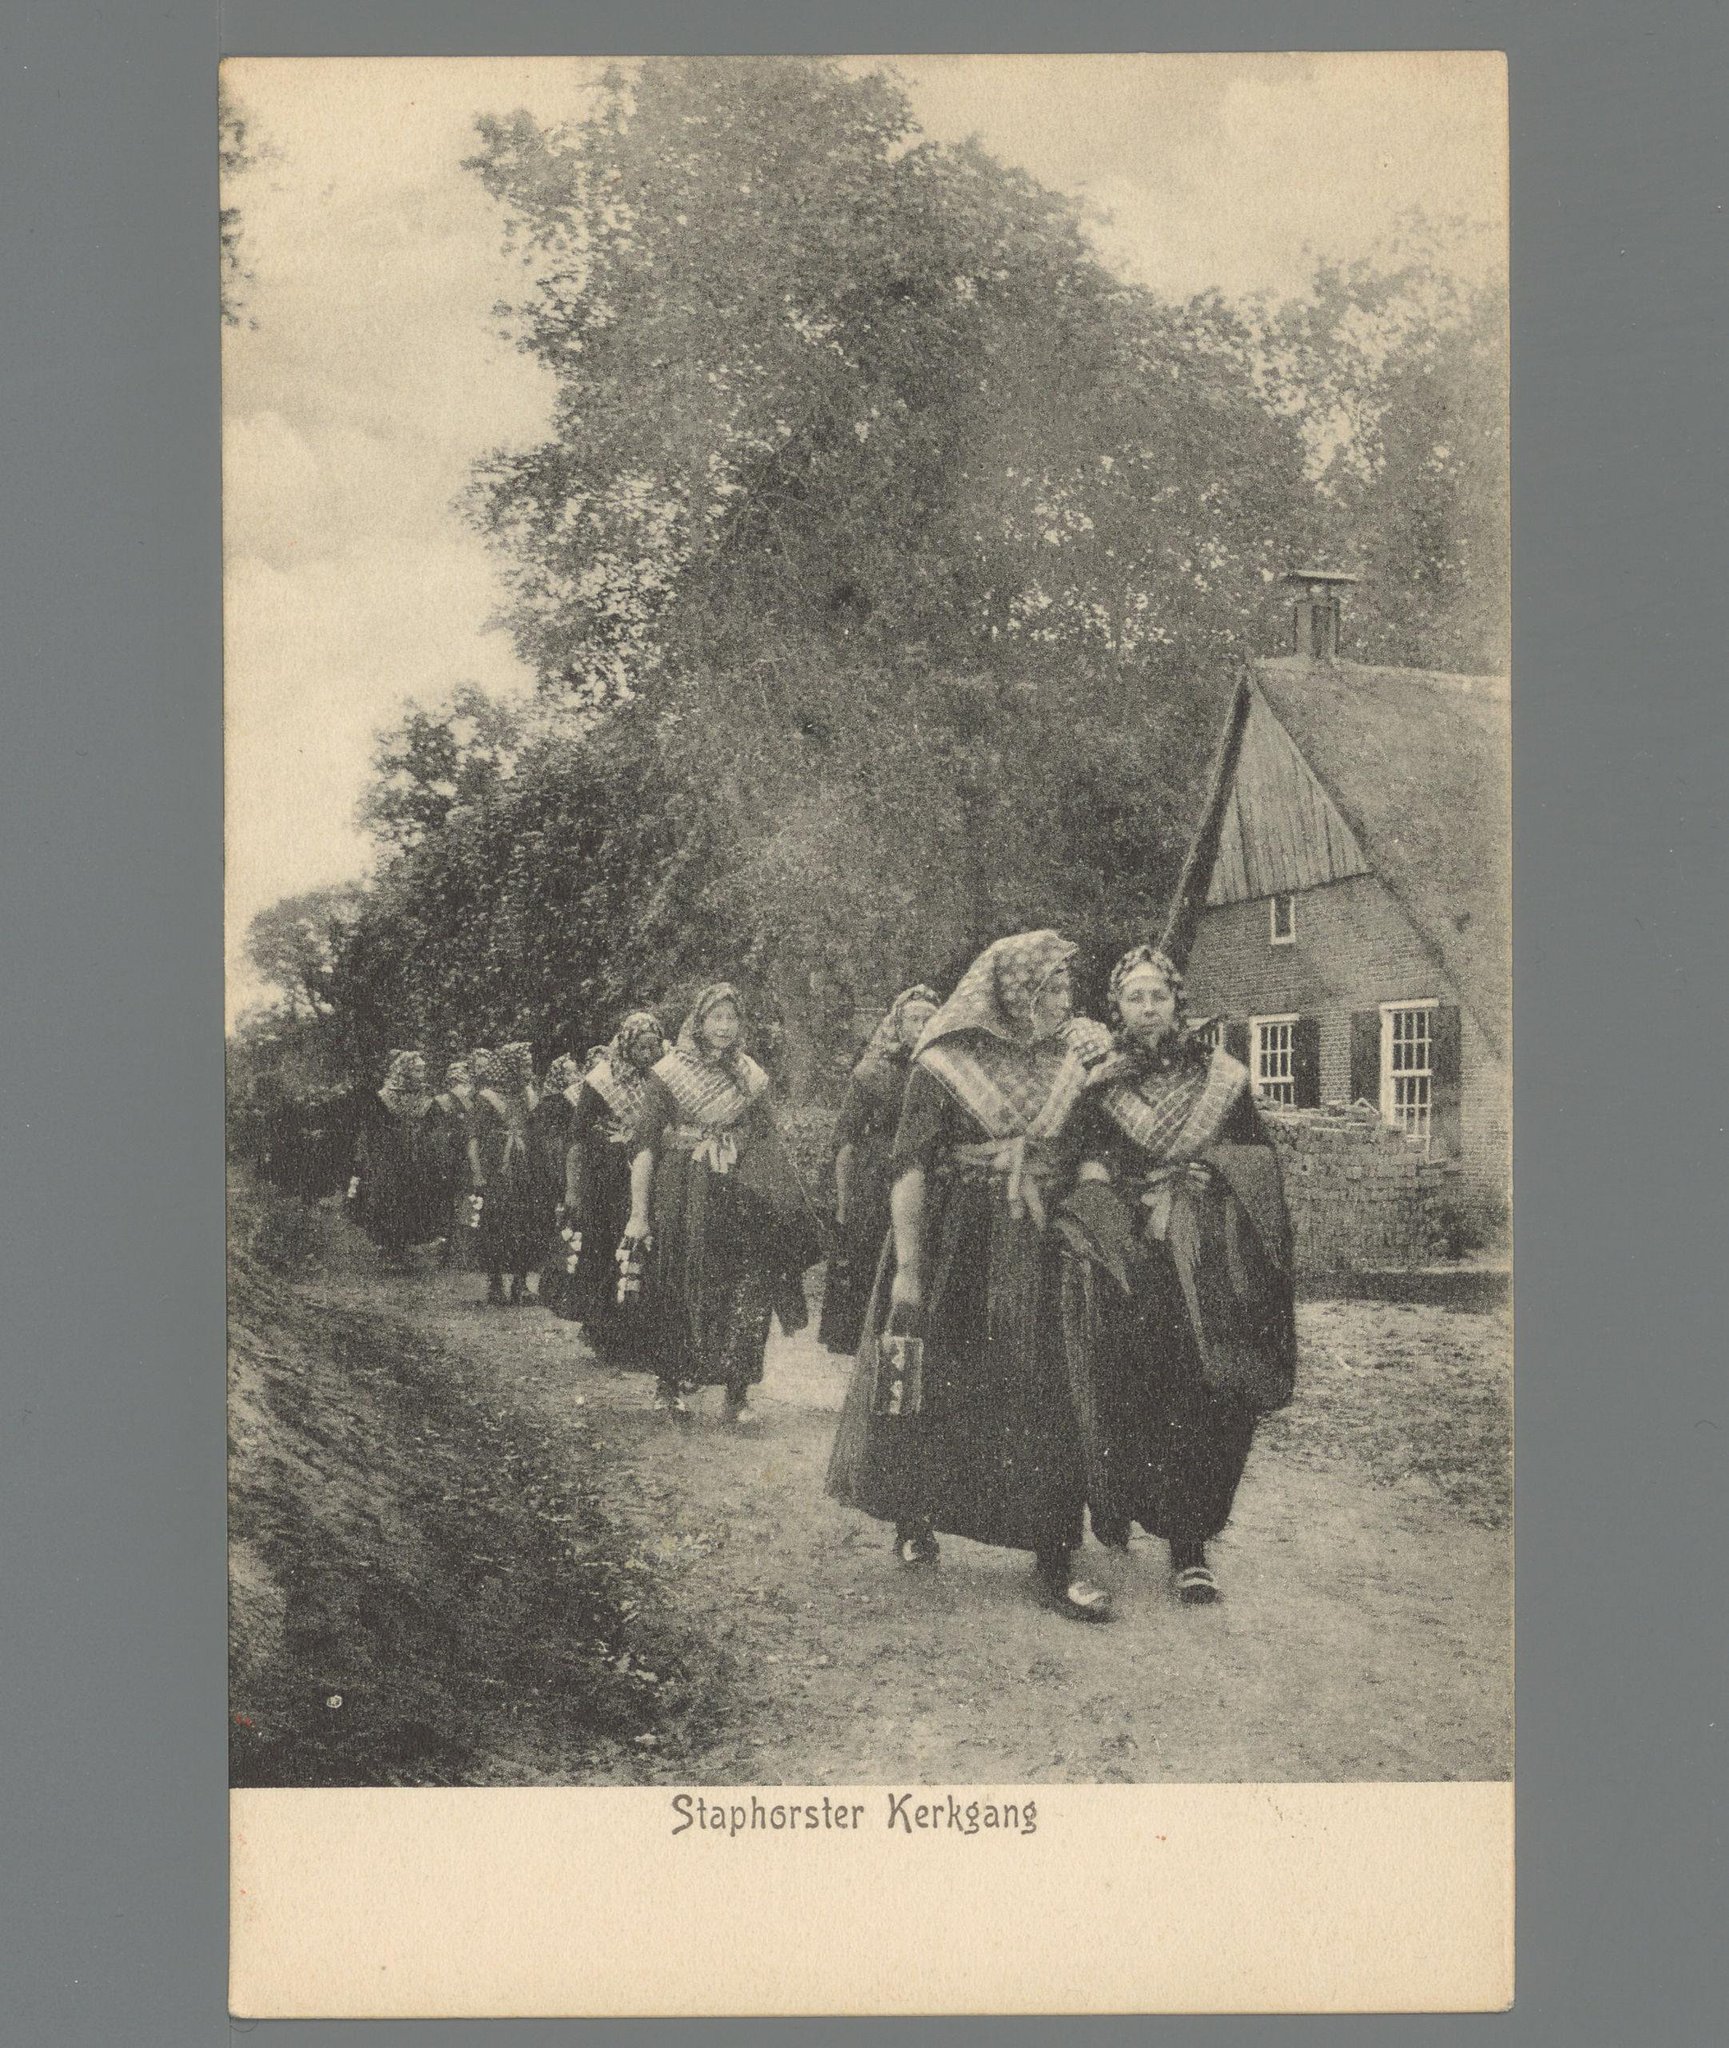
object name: photomechanical print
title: Staphorster Kerkgang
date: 1905-1930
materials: cardboard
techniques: photograph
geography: staphorst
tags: leaving the church after service